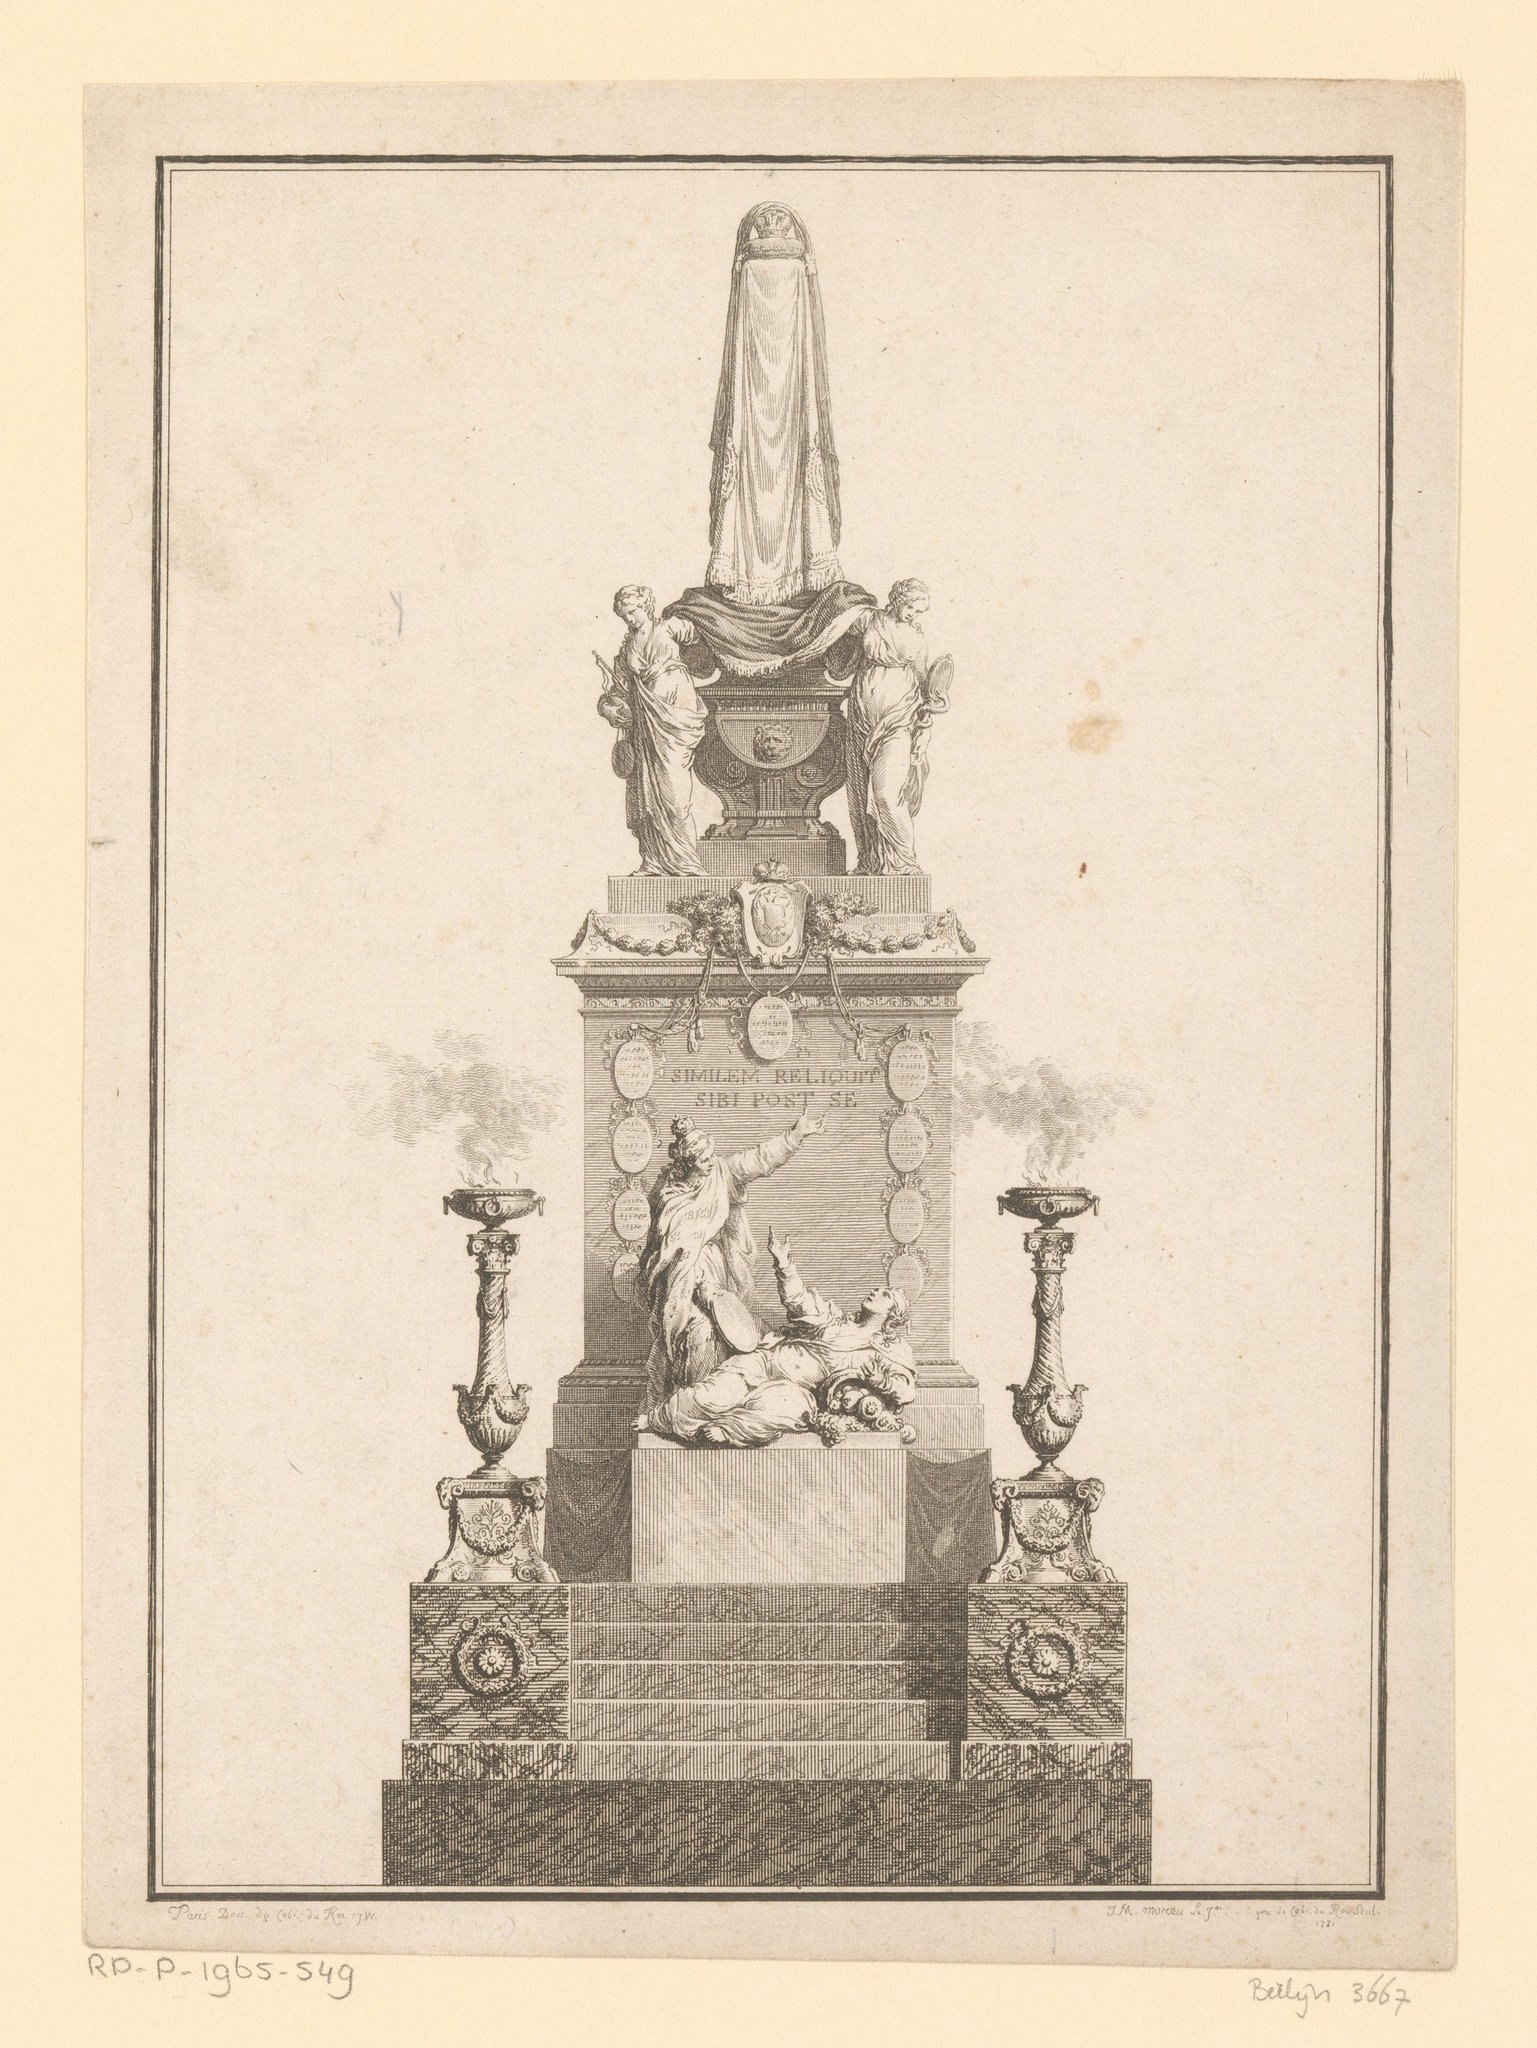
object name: ornament print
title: Katafalk van keizerin Maria Theresia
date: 1781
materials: paper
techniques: engraving, etching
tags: vienna, maria theresia (rooms-duits keizerin), catafalque, 'castrum doloris' (~ public funeral)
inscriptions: collector's mark: Lugt 2760, collector's mark: Lugt 2228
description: Katafalk in de Notre Dame te Parijs bij de begrafenis van Maria Theresia op 30 mei 1781. Bovenop een verhoging bevindt zich de doodskist met kroon, draperieën en twee deugden. Voor de verhoging twee rookvaten op voetstukken en een staande vrouw met kroon en liggende vrouw met een hoorn des overvloeds.